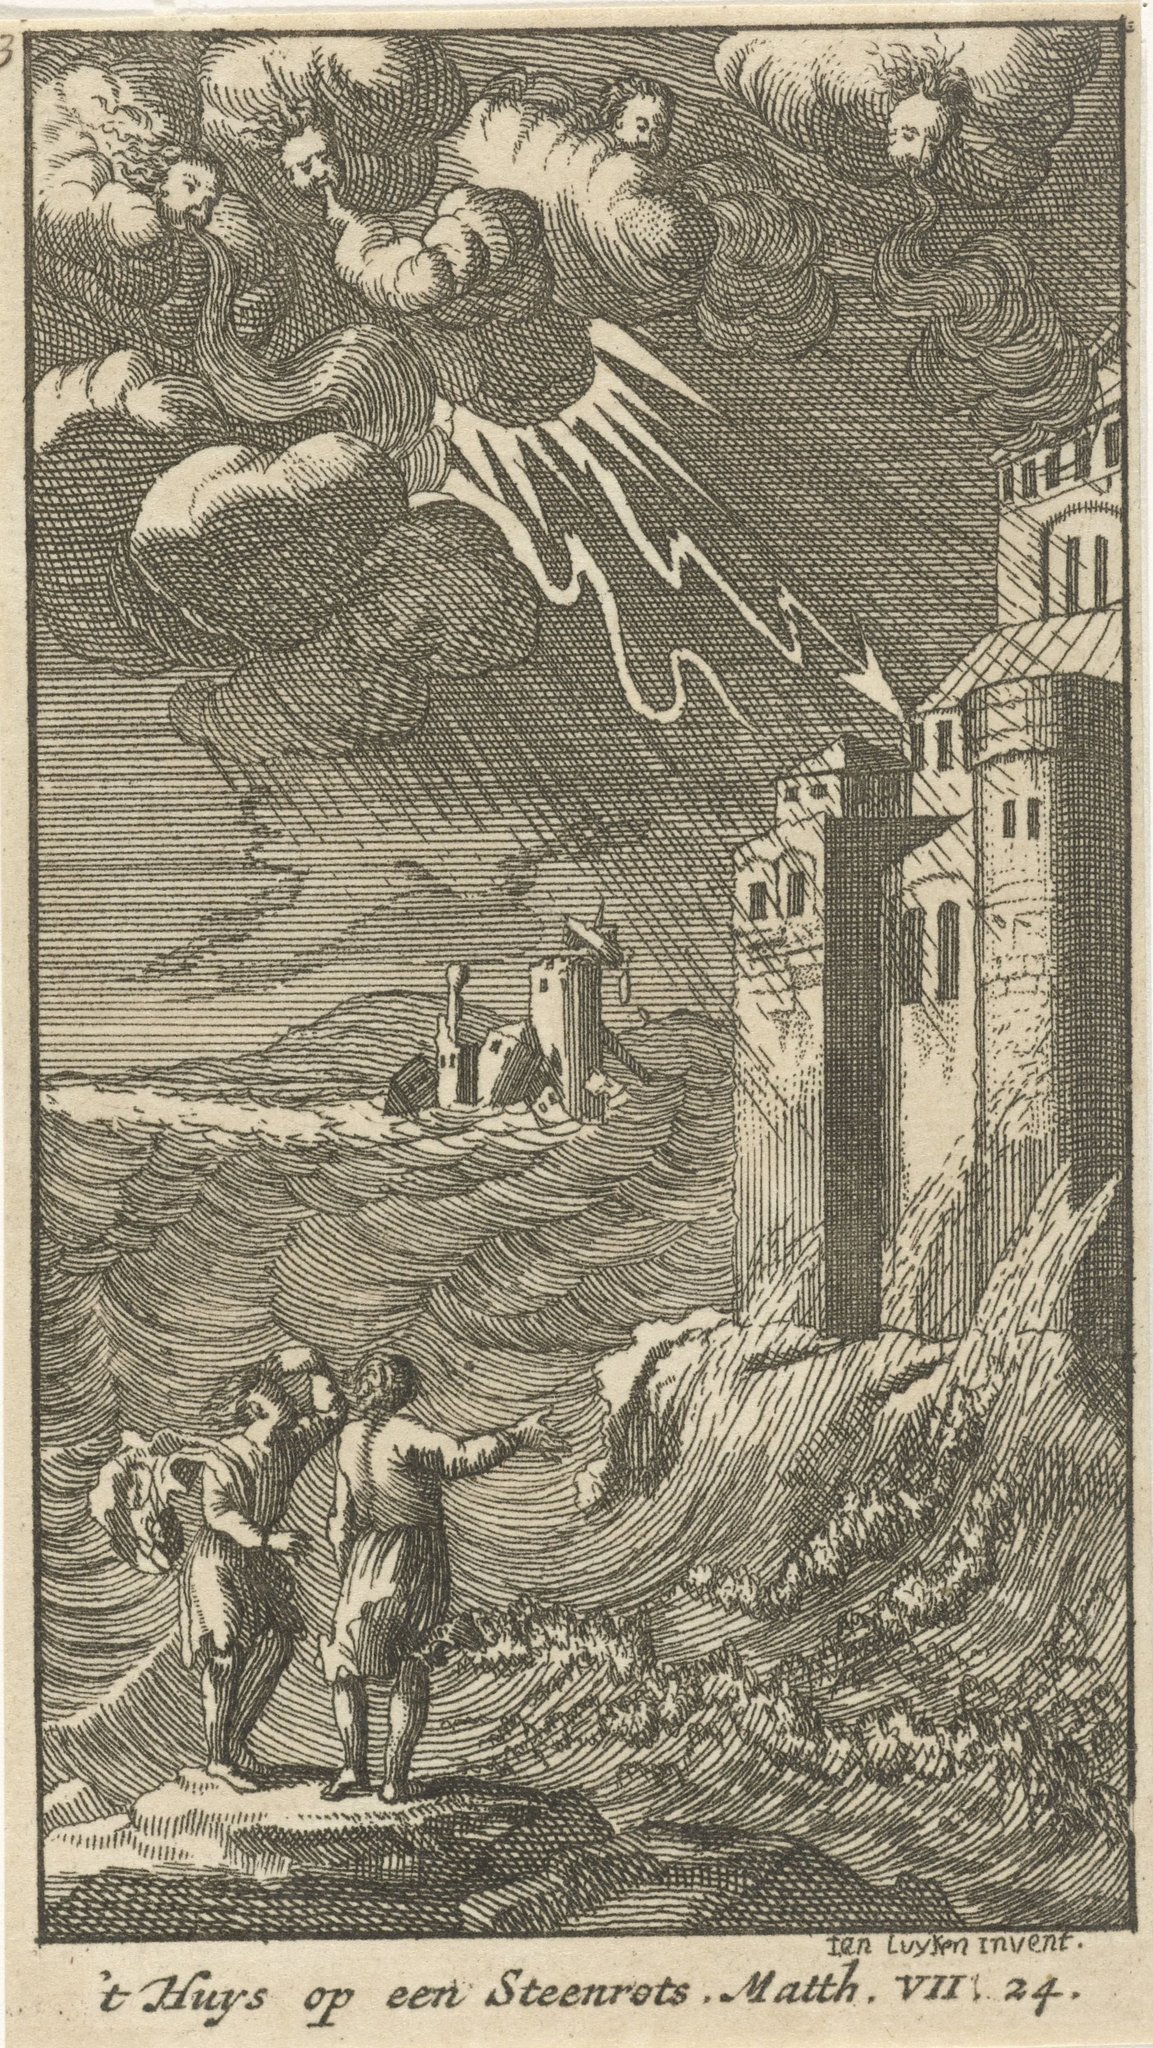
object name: print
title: Het huis op de rots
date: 1720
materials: paper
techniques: etching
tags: house built upon a rock; house built upon sand ~ doctrine of christ on love, etc. (matthew 7:24-27; luke 6:47-49)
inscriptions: collector's mark: Lugt 2228, number: ‘3’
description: Prent opgenomen in: Het Nieuw Testament onzes Heere Jesus Christus. Amsterdam: Wed. Albert Klumper en Jan Kalverum, 1720. In dit boek is de gehele serie met 24 scènes uit het Nieuwe Testament naar Jan Luyken opgenomen. De originele prent door J. Luyken verscheen mogelijk voor het eerst in: Het Nieuwe Testament ofte alle Boecken des Nieuwen Verbondts onses Heeren Iesu Christi. Amsterdam: Hieronymus Sweerts, Jan ten Hoorn, Jan Bouman en Daniel van den Dalen, 1681.